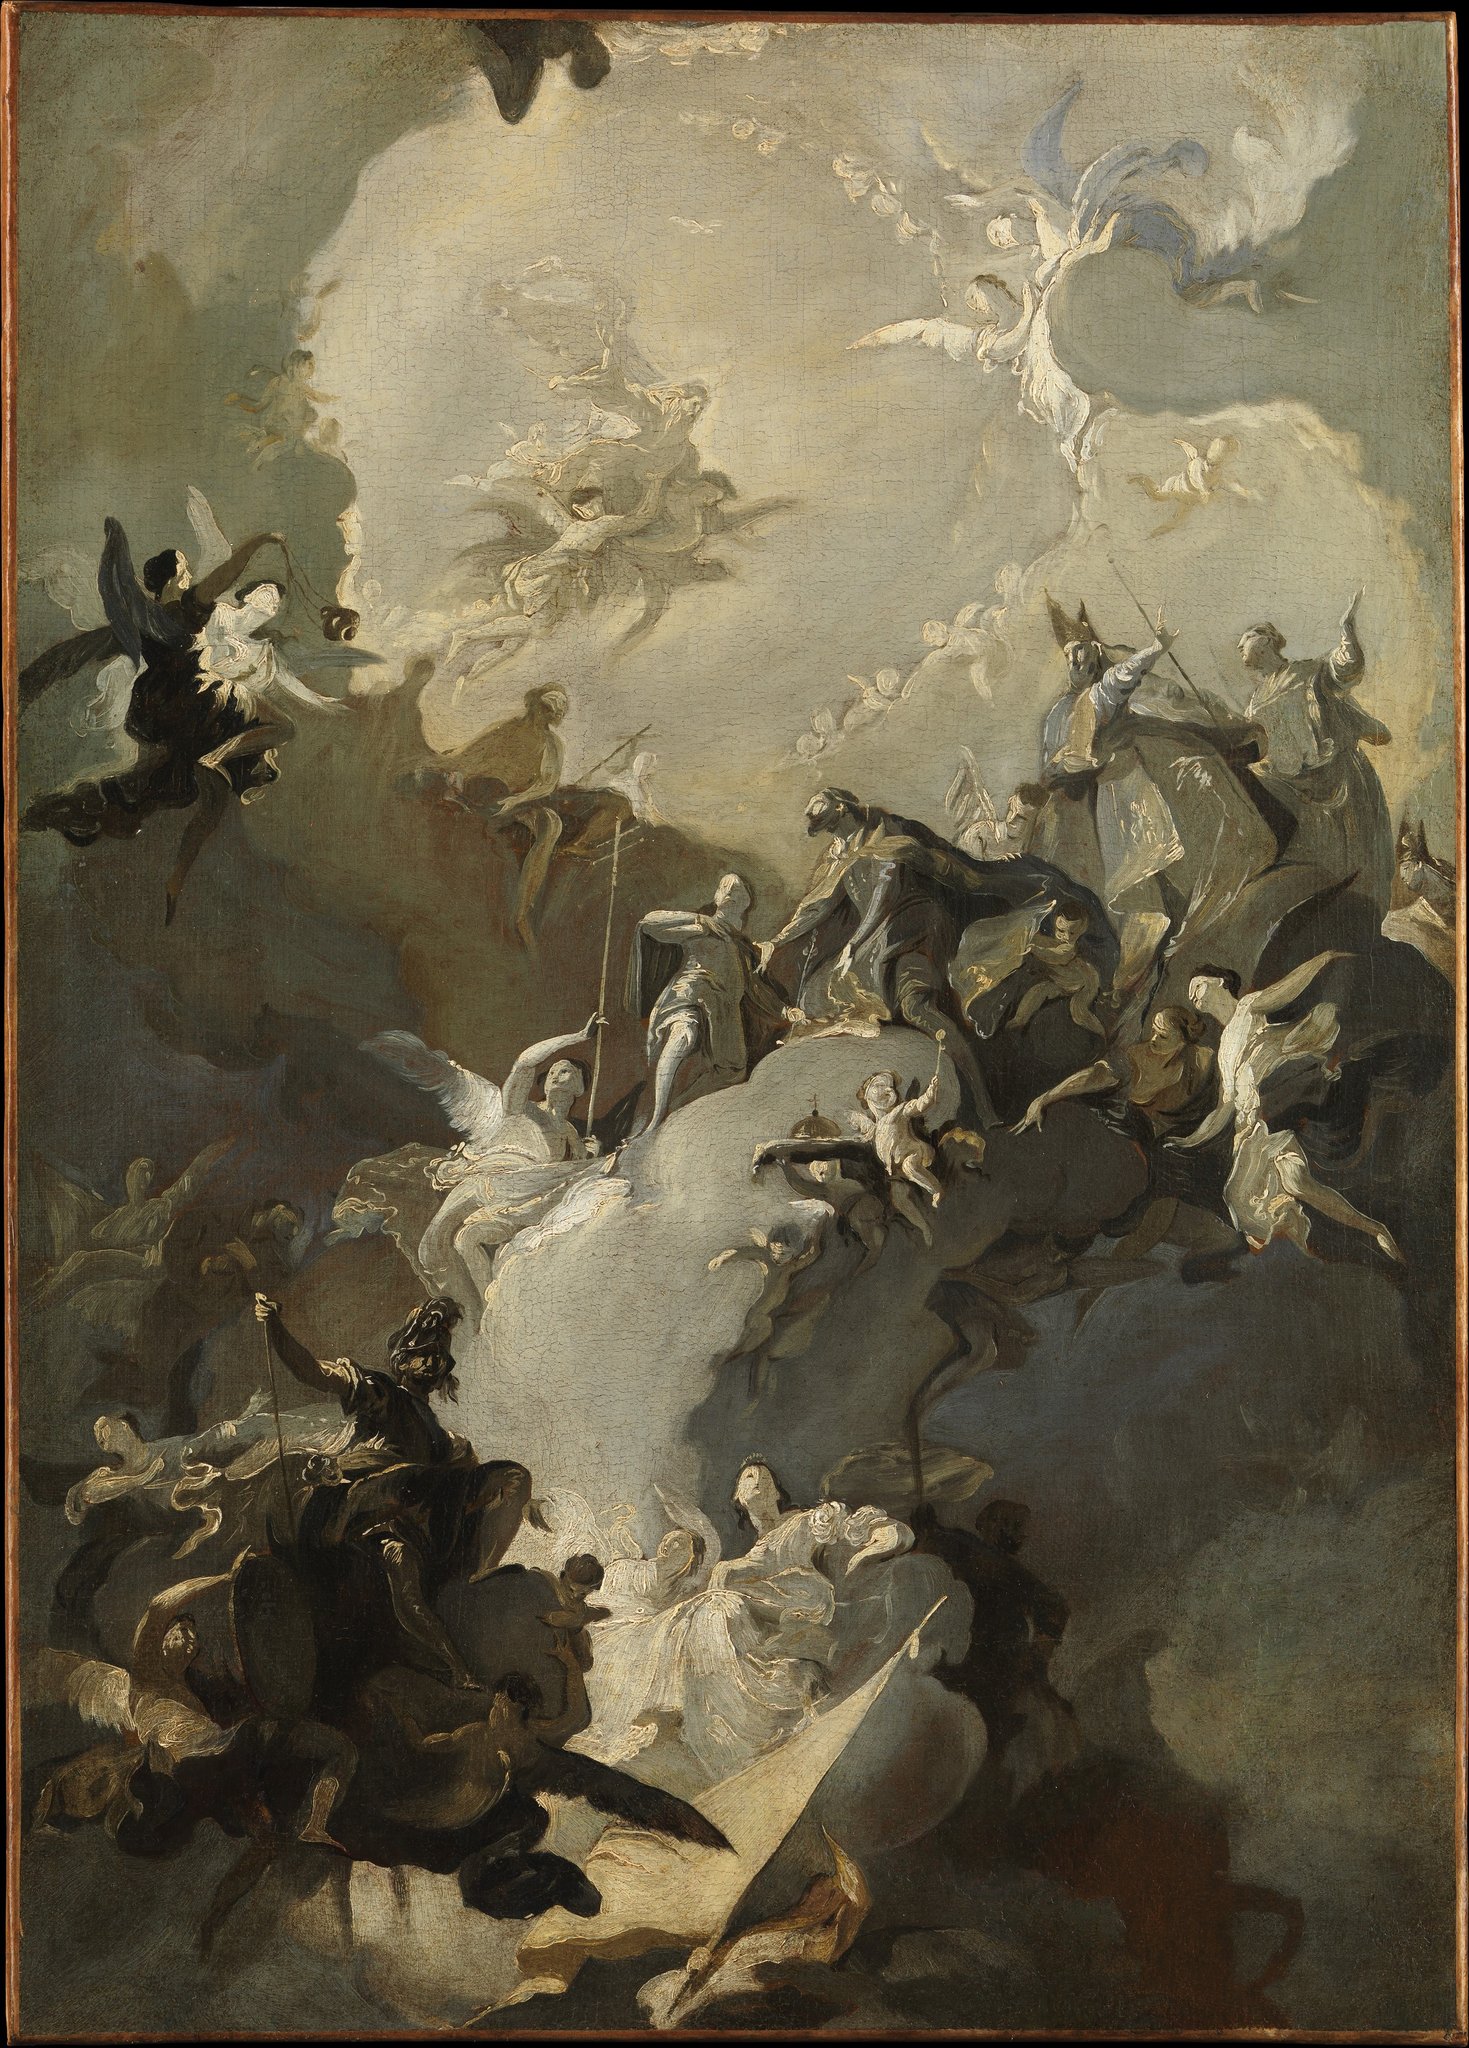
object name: painting, grisaille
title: The Glorification of the Royal Hungarian Saints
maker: franz anton maulbertsch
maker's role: artist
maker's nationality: austrian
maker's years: 1724-1796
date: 1772-1773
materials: canvas, oil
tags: clouds,saints